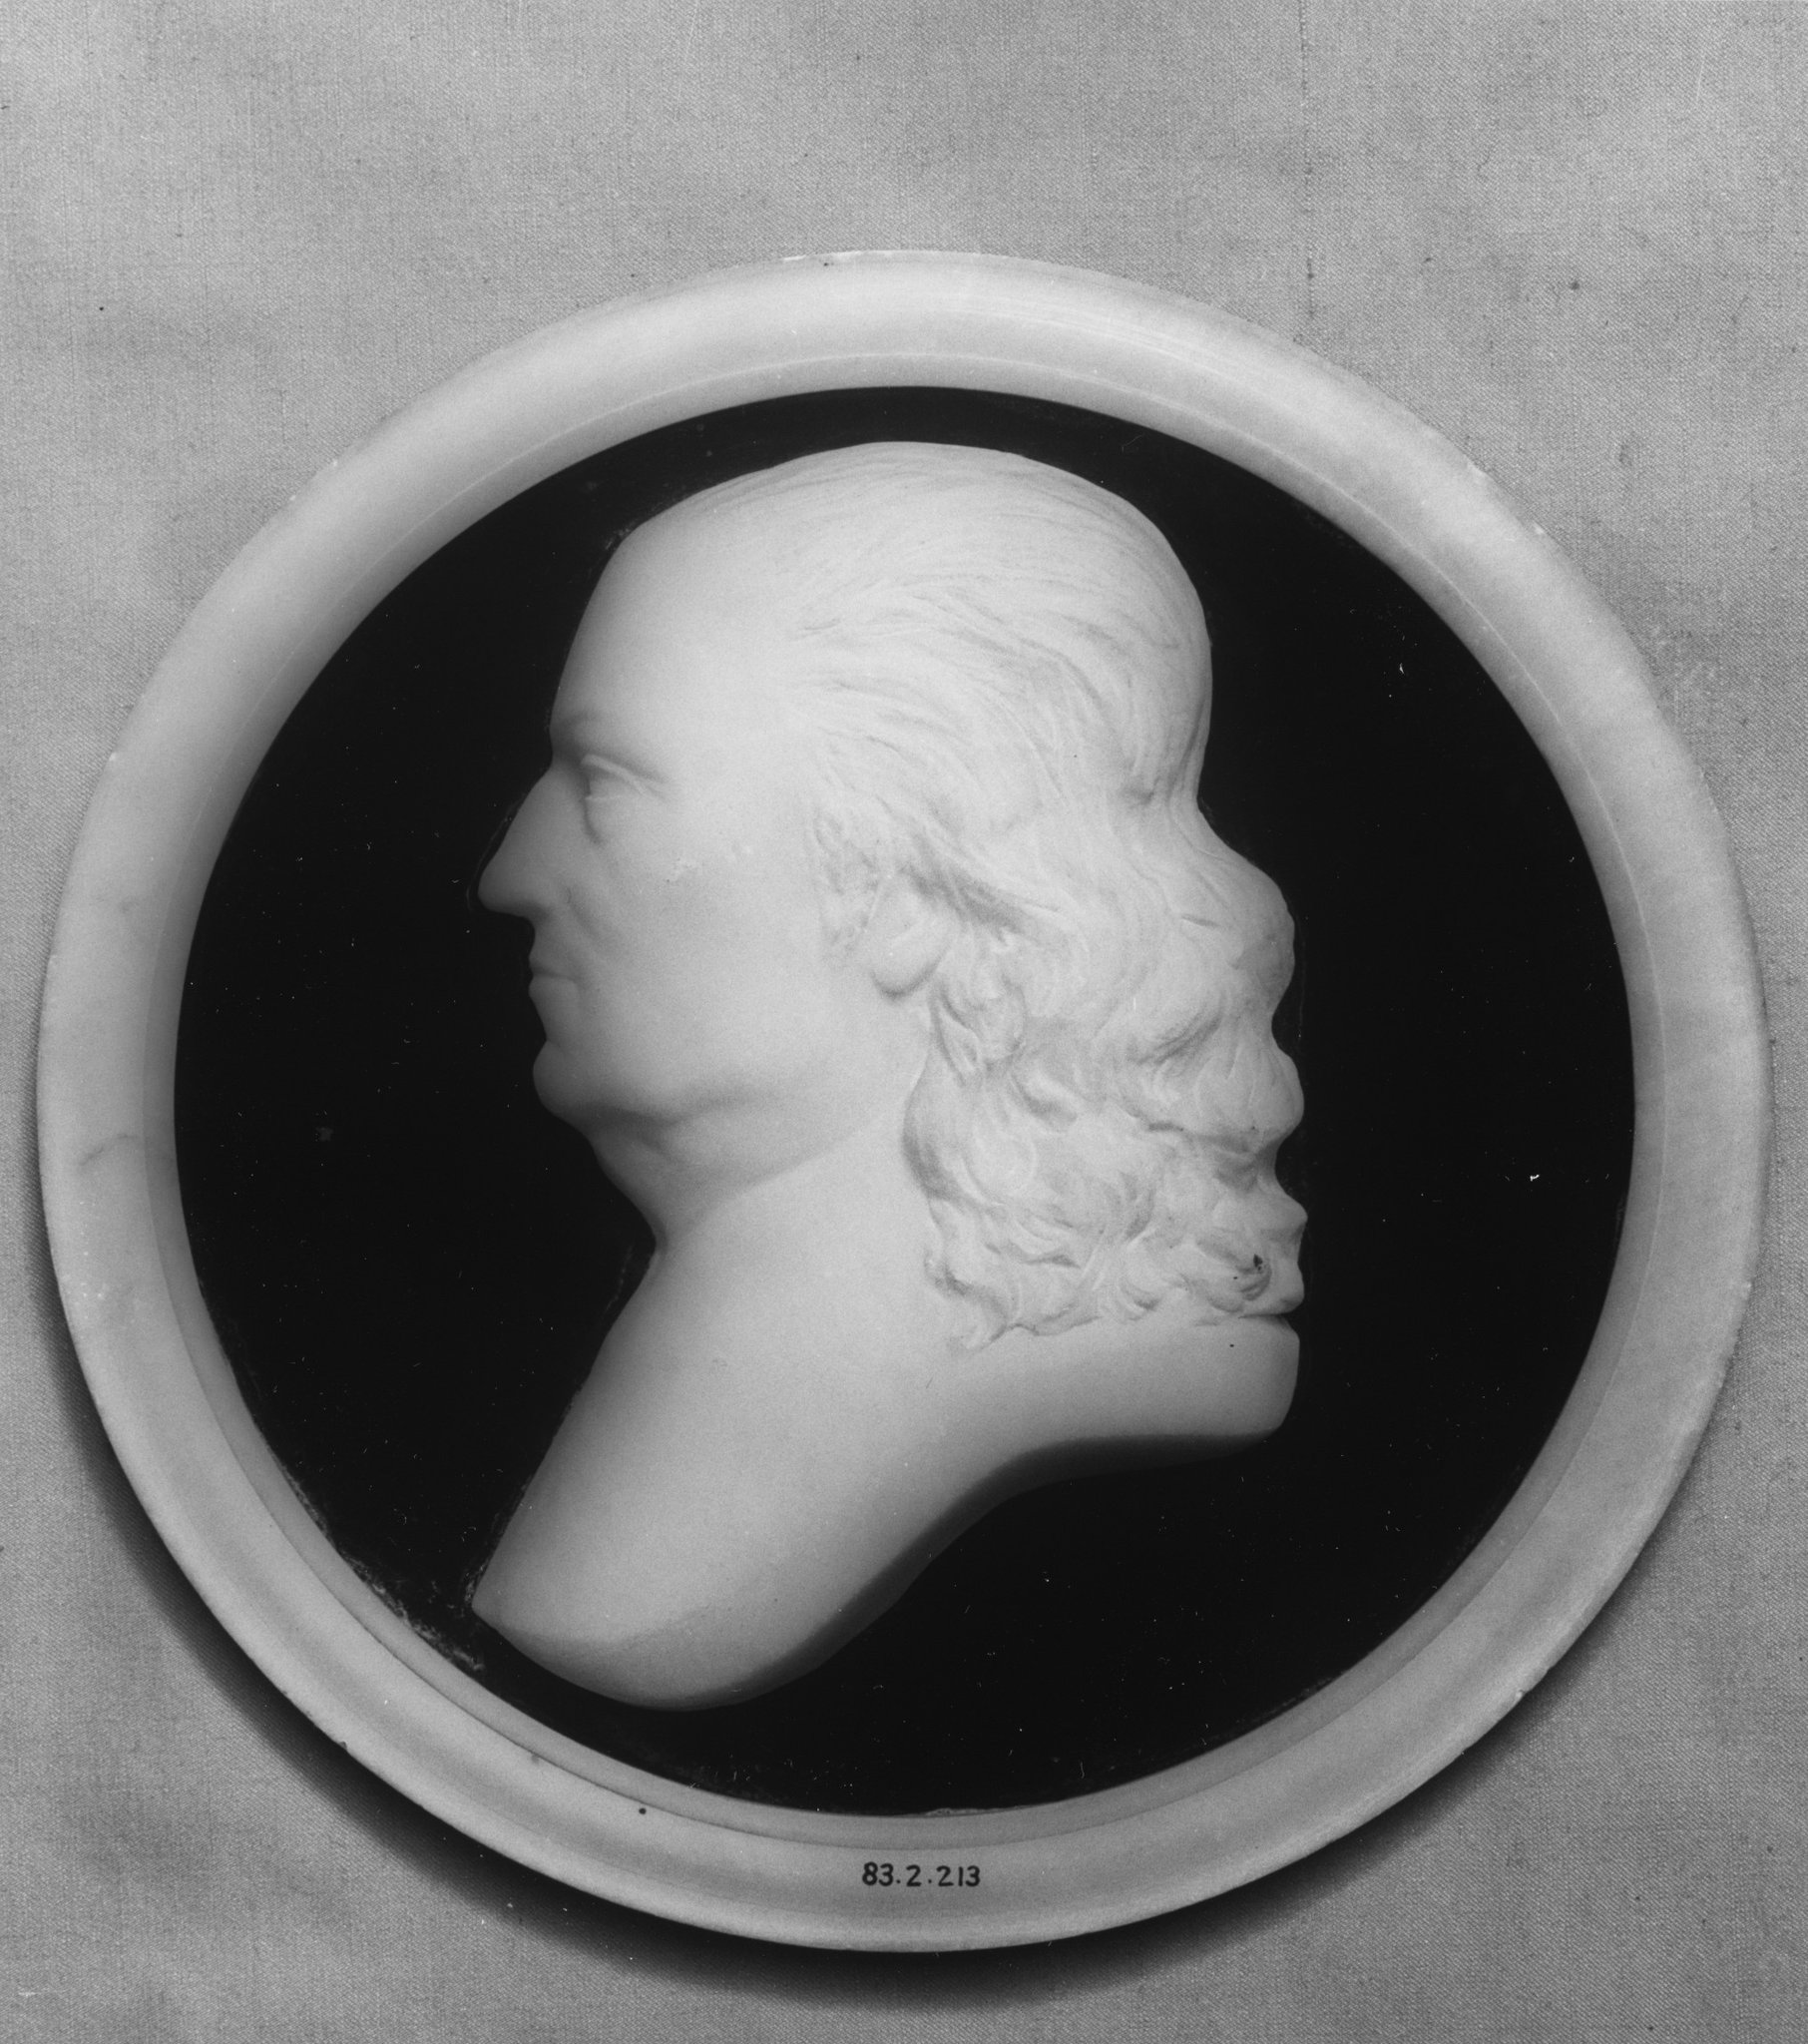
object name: medallion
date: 1800-1883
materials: alabaster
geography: italy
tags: benjamin franklin,men,profiles